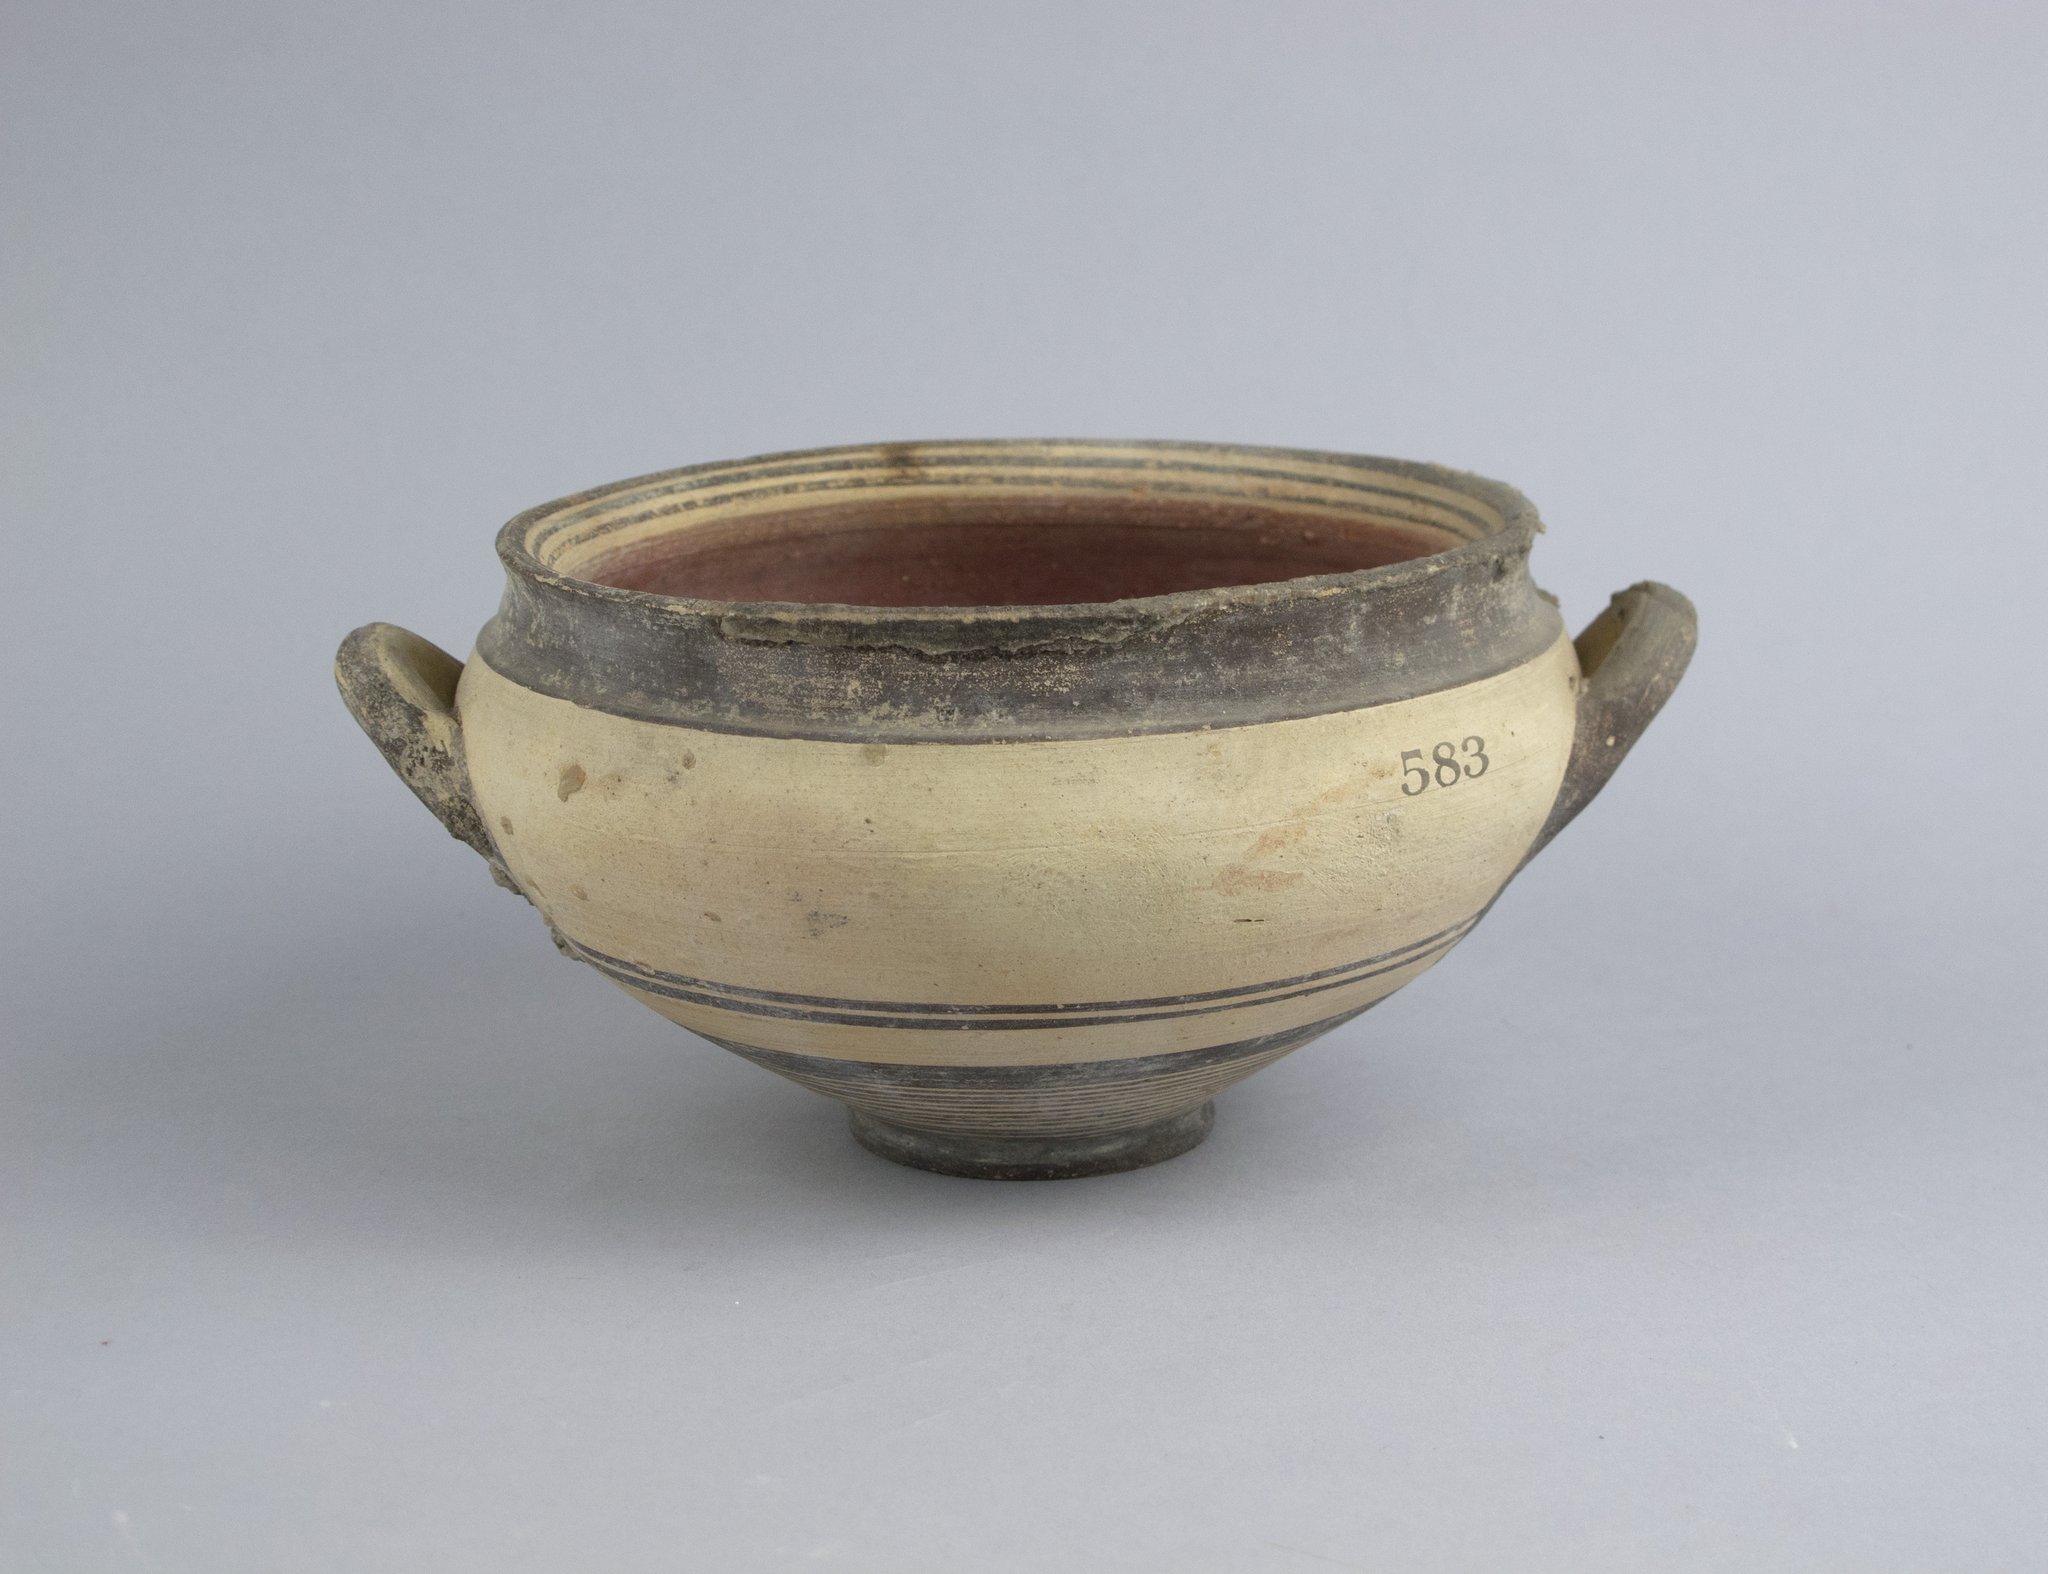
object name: bowl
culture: cypriot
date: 850-750 BCE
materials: terracotta